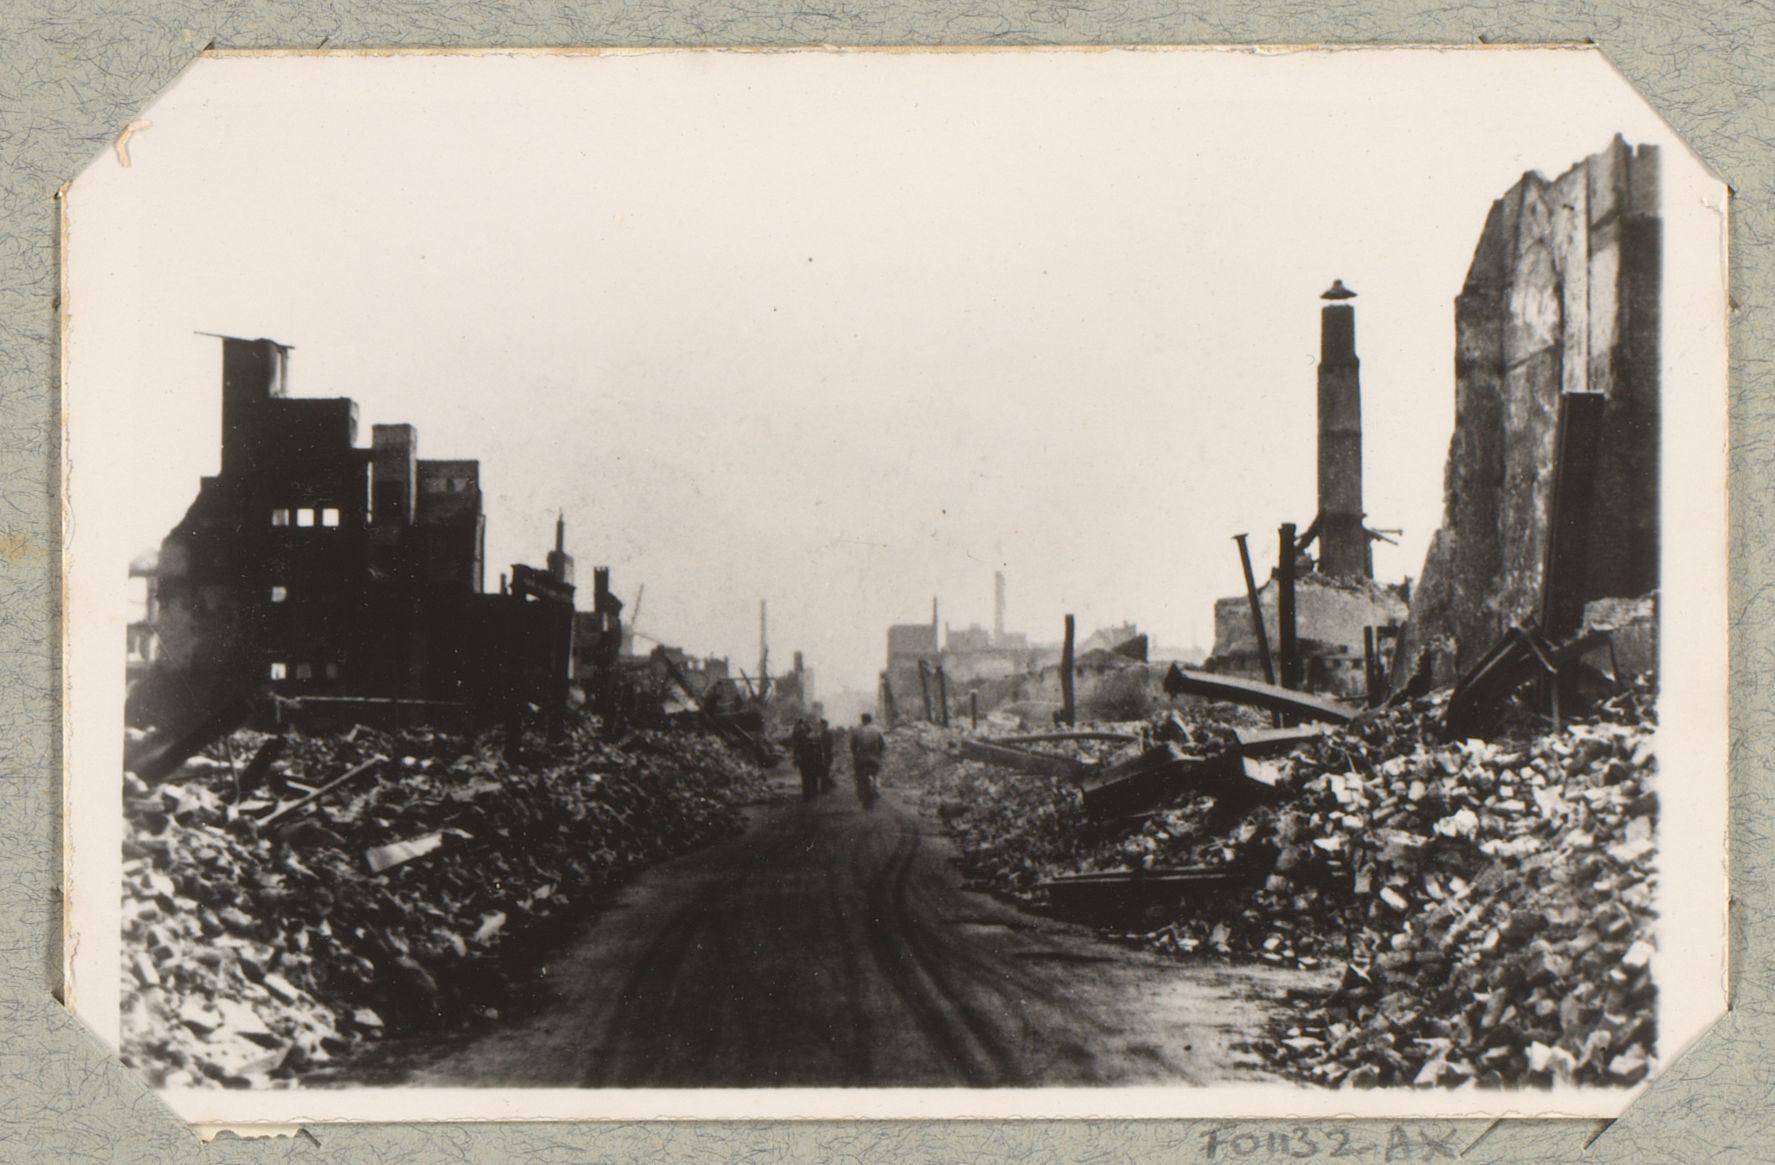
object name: photograph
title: Ruïnes van gebouwen aan de Hoogstraat te Rotterdam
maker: j. nolte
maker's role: fotograaf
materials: photographic support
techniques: gelatin silver print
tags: devastated, ruined place or city (~ warfare), street, ruin of a dwelling, house, castle, etc., rotterdam, rotterdam blitz